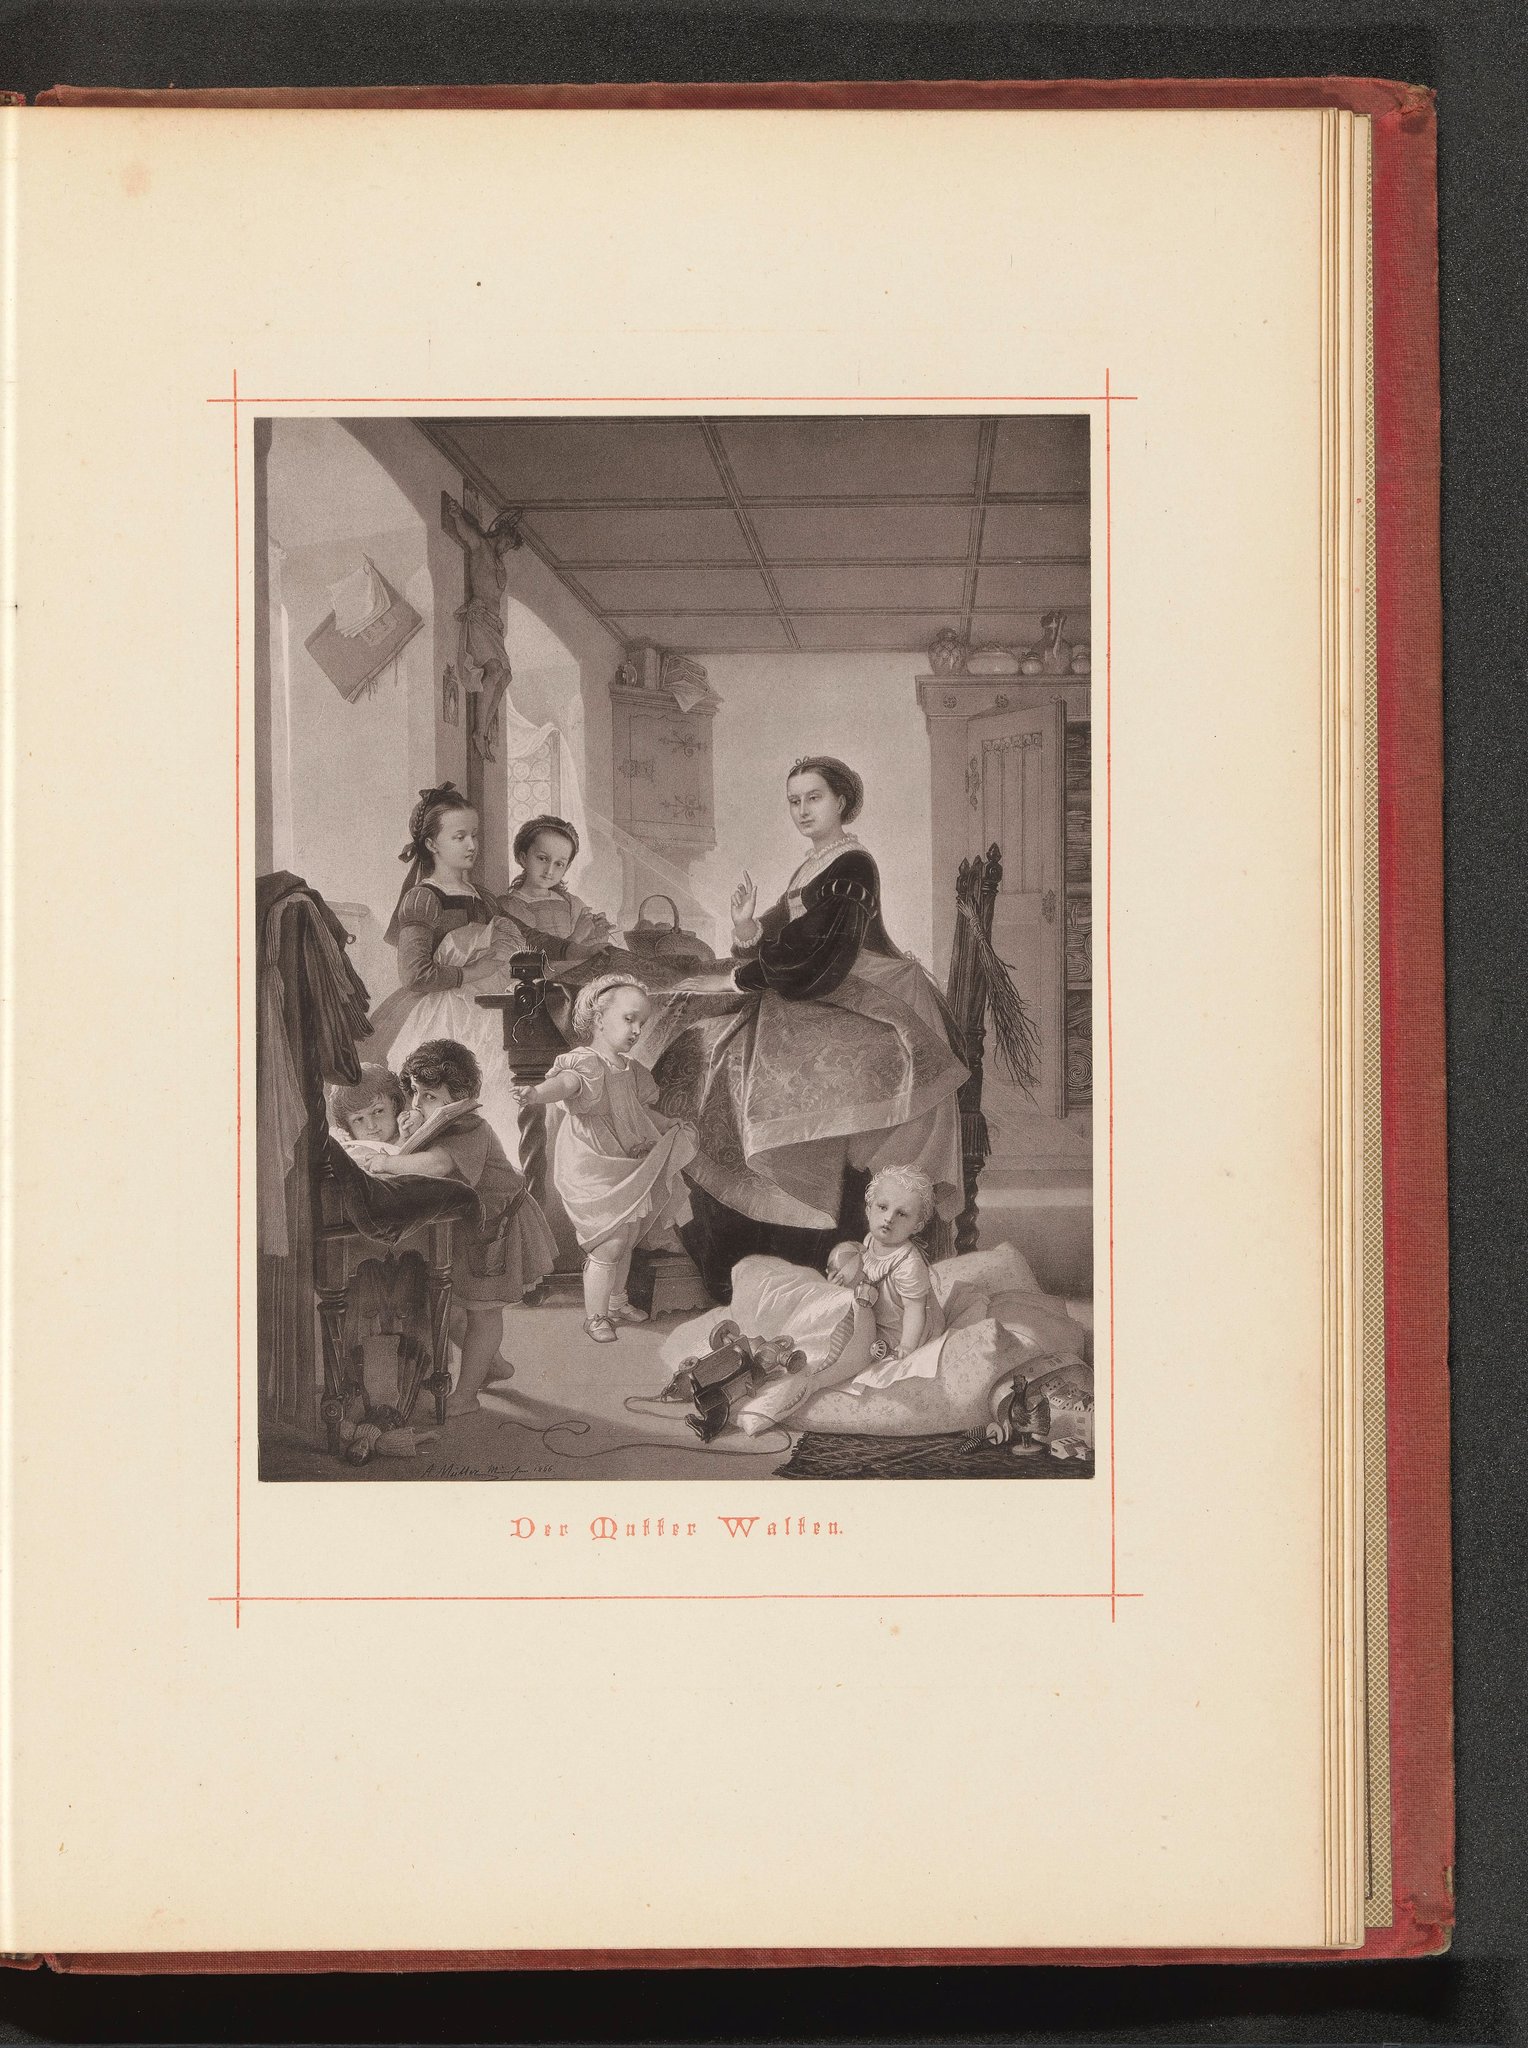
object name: photomechanical print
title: Fotoreproductie van een tekening van een vrouw met zes kinderen in een kamer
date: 1871-1881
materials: paper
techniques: photograph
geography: germany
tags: taking care of children